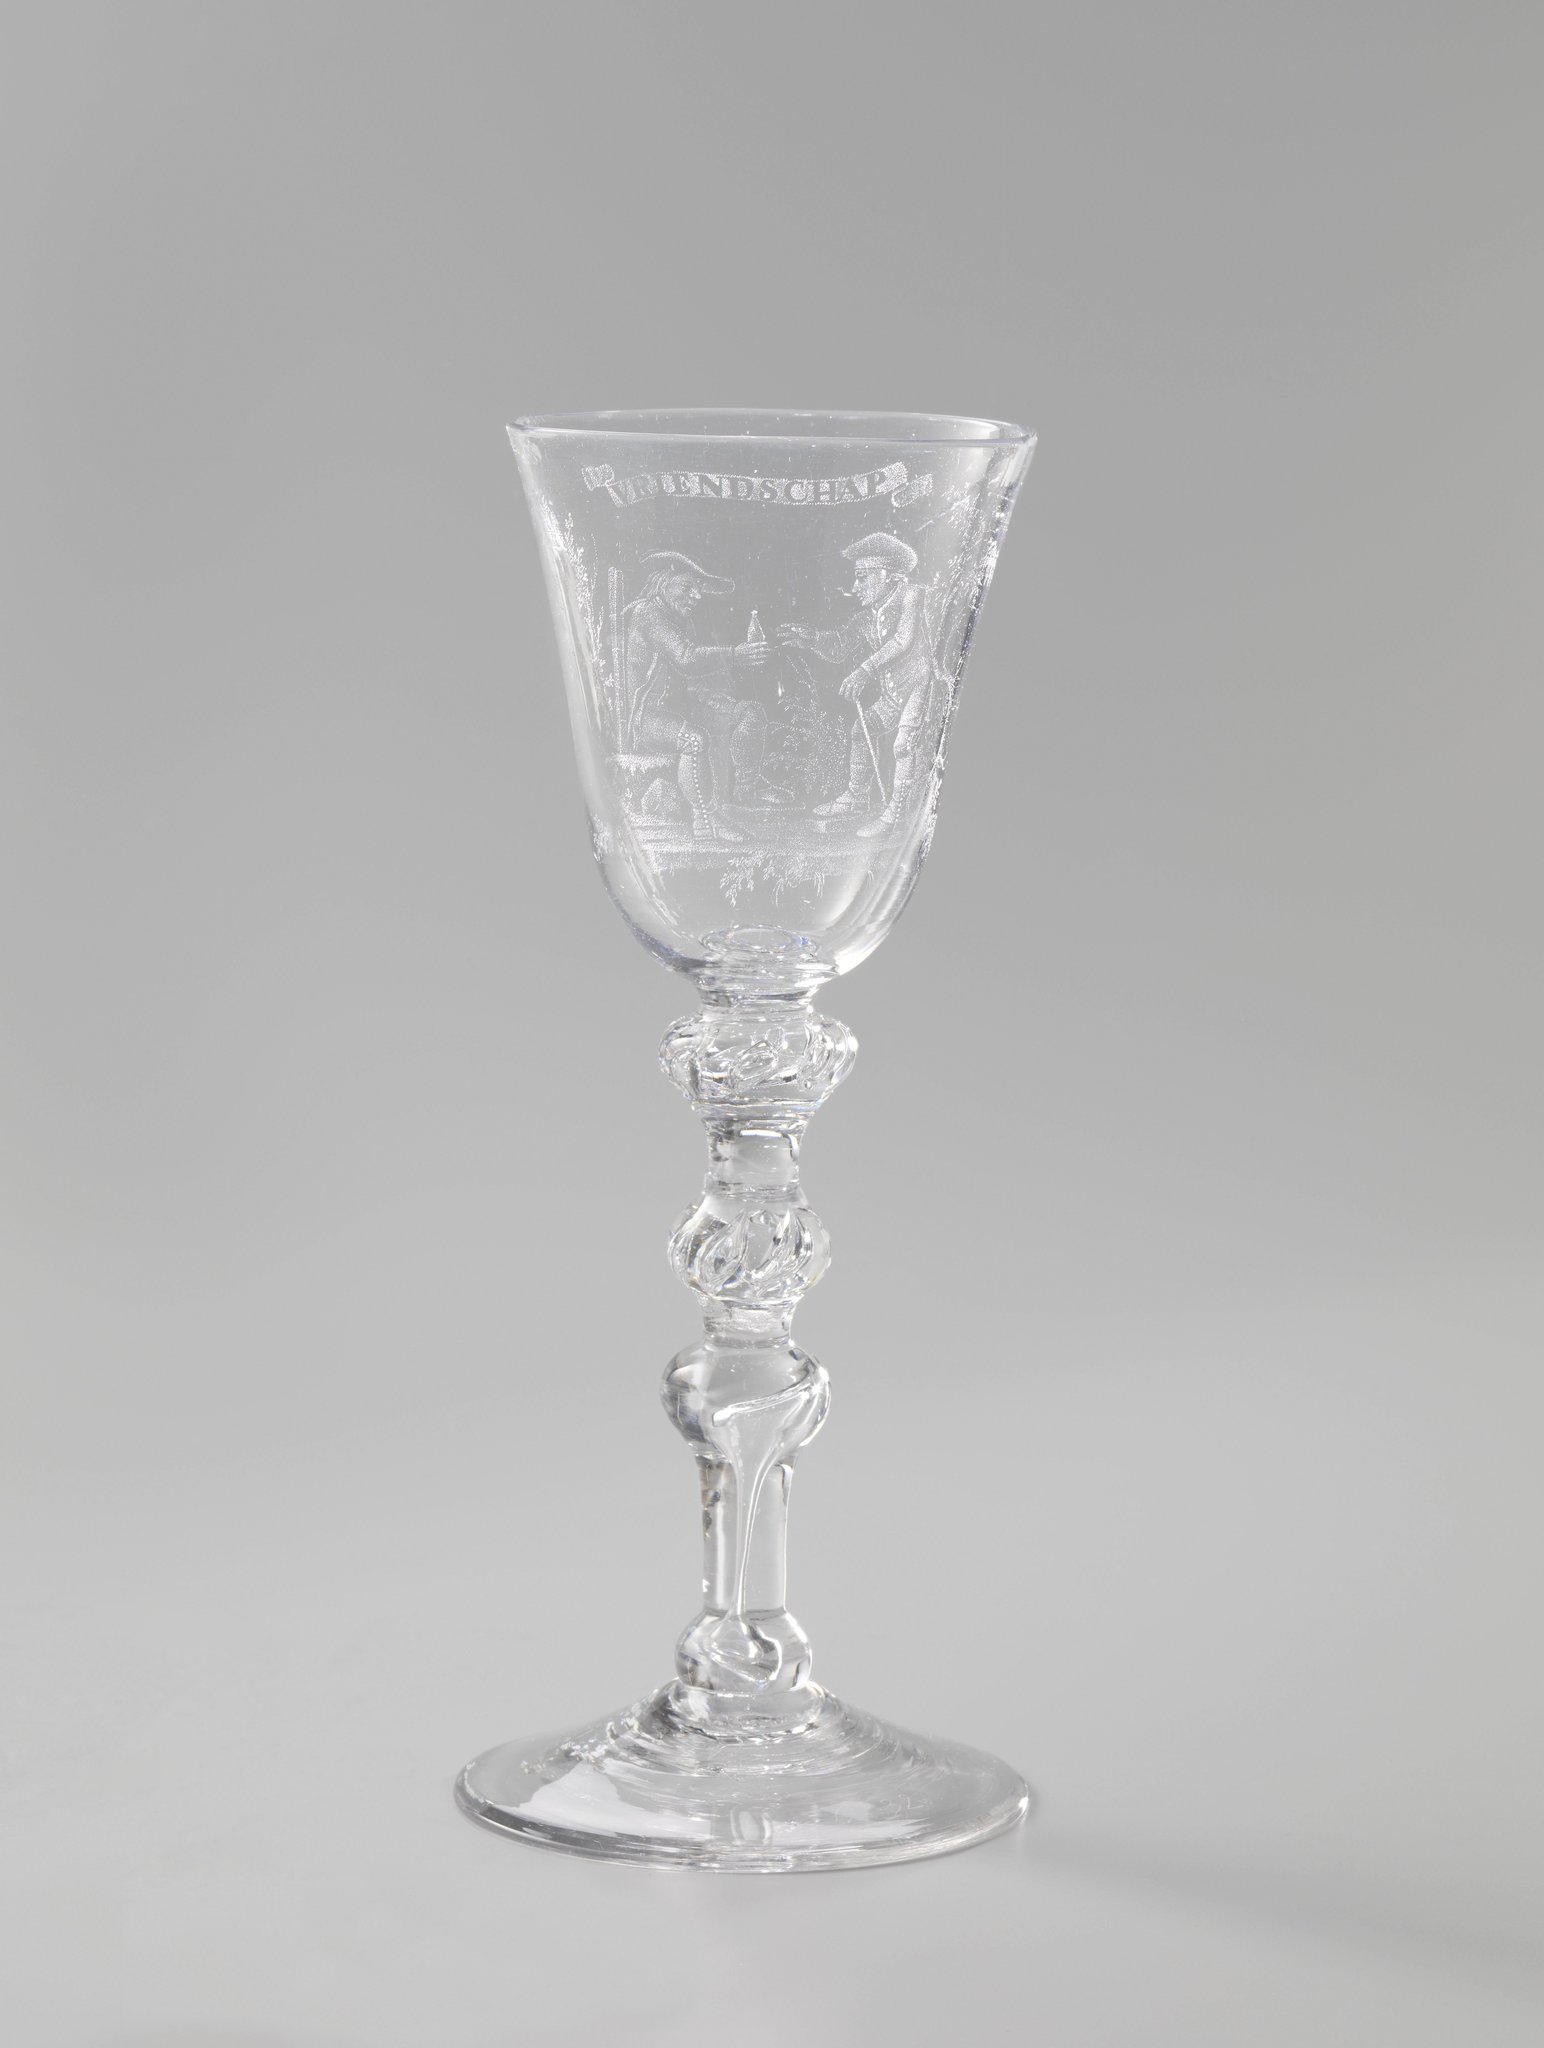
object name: goblet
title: Wine glass with two men drinking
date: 1760-1780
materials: glass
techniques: glassblowing, engraving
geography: southern netherlands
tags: bottle of wine, friends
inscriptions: inscription: ‘VRIENDSCHAP’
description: translation of inscription: Friendship